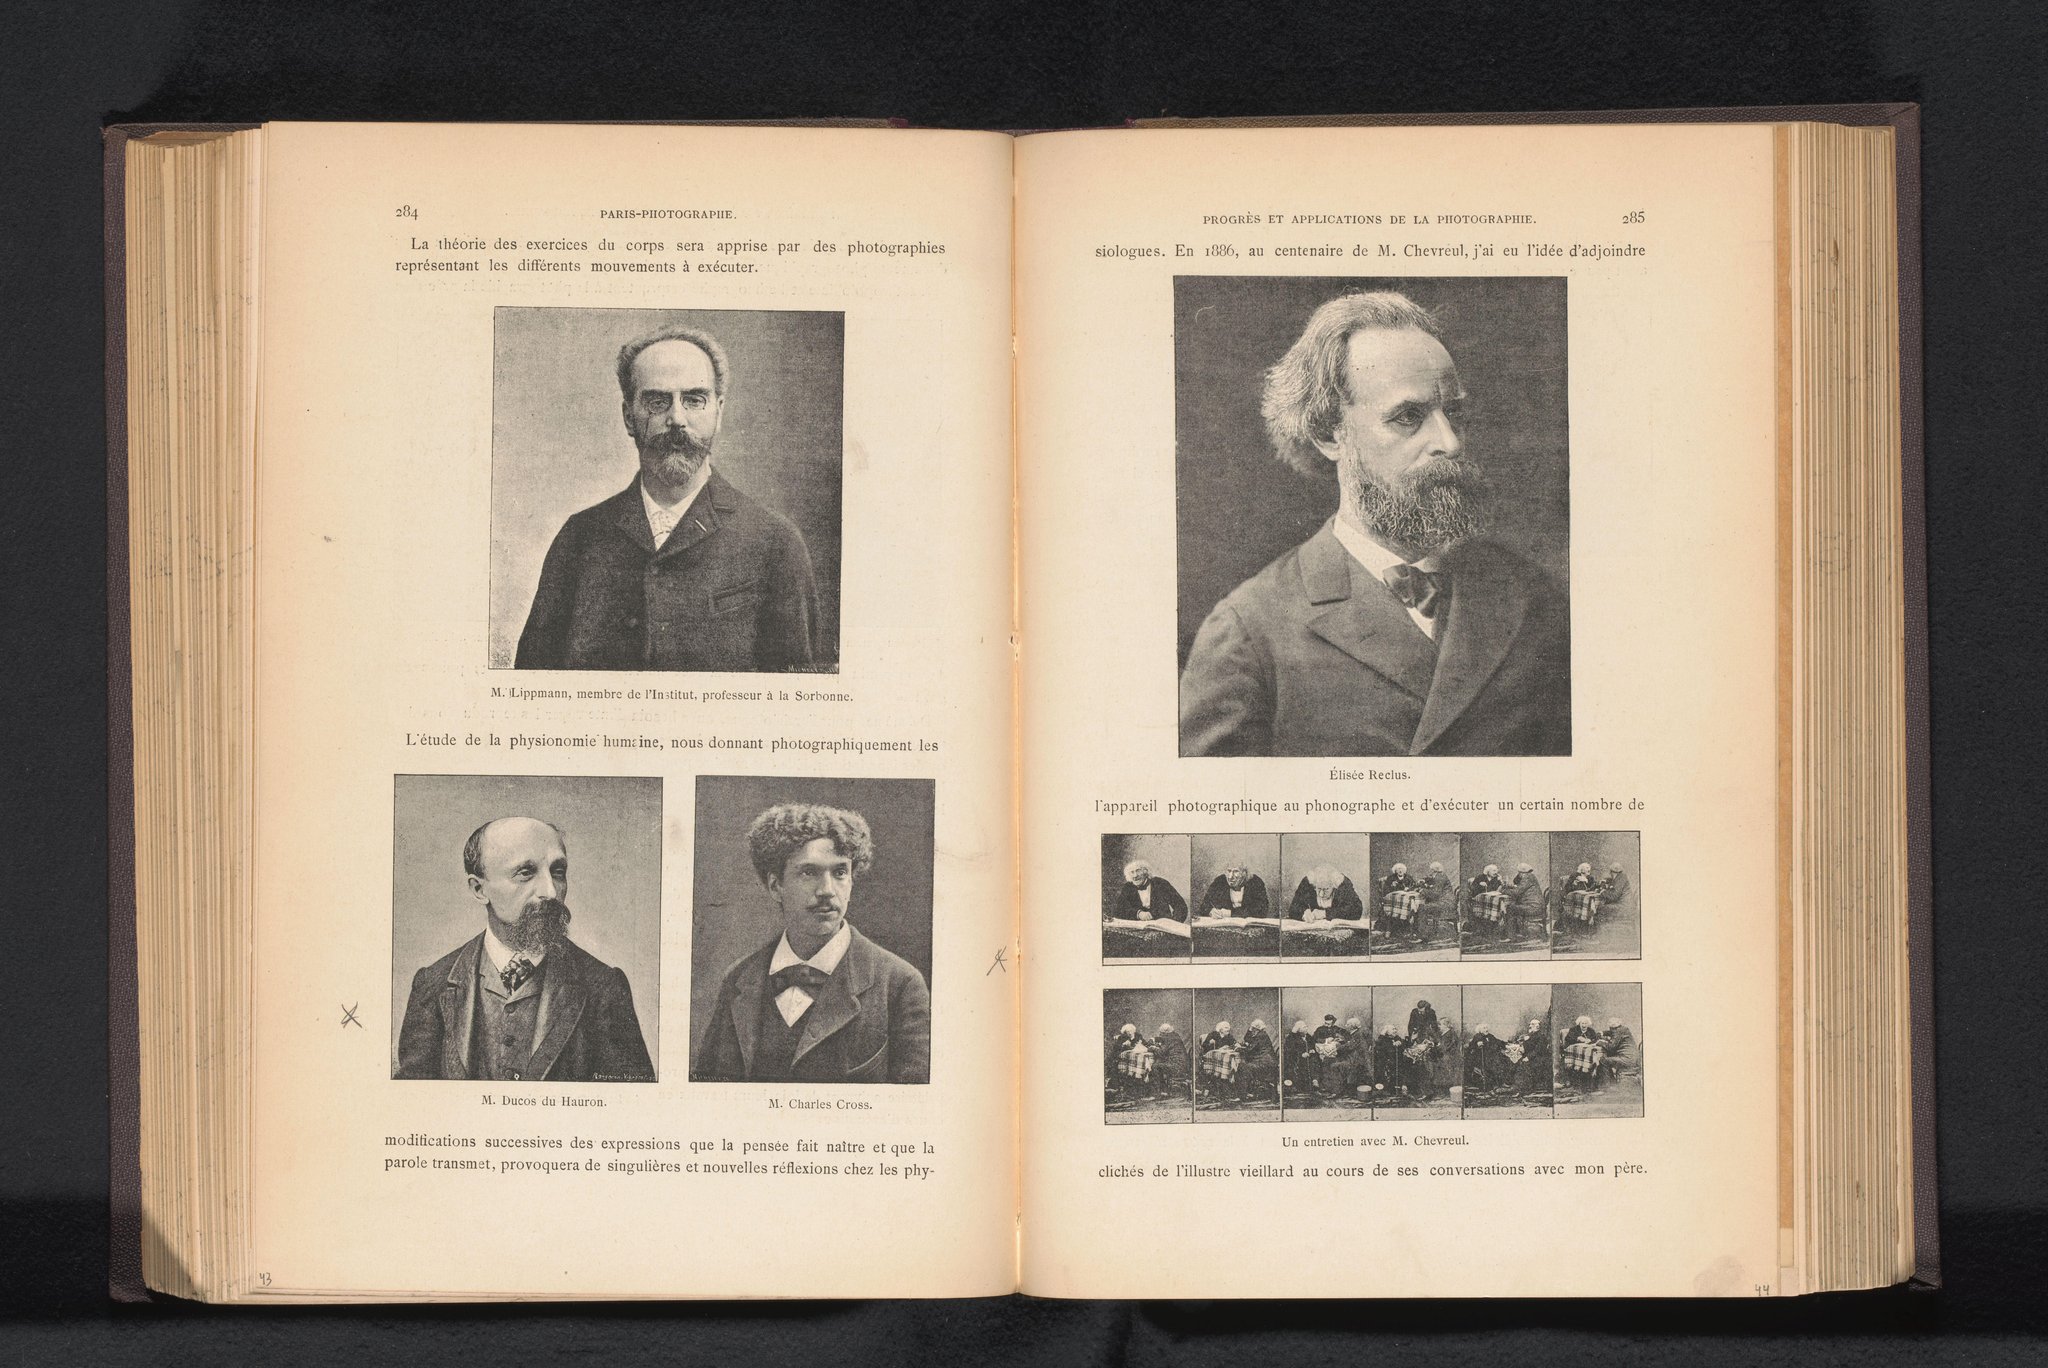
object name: page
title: Portretten van Gabriel Lippmann, Louis Arthur Ducos du Hauron en vermoedelijk Charles Frederick Cross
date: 1882-1892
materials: paper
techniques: autotype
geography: france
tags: louis ducos du hauron, physicist, gabriel jonas lippmann, adult man